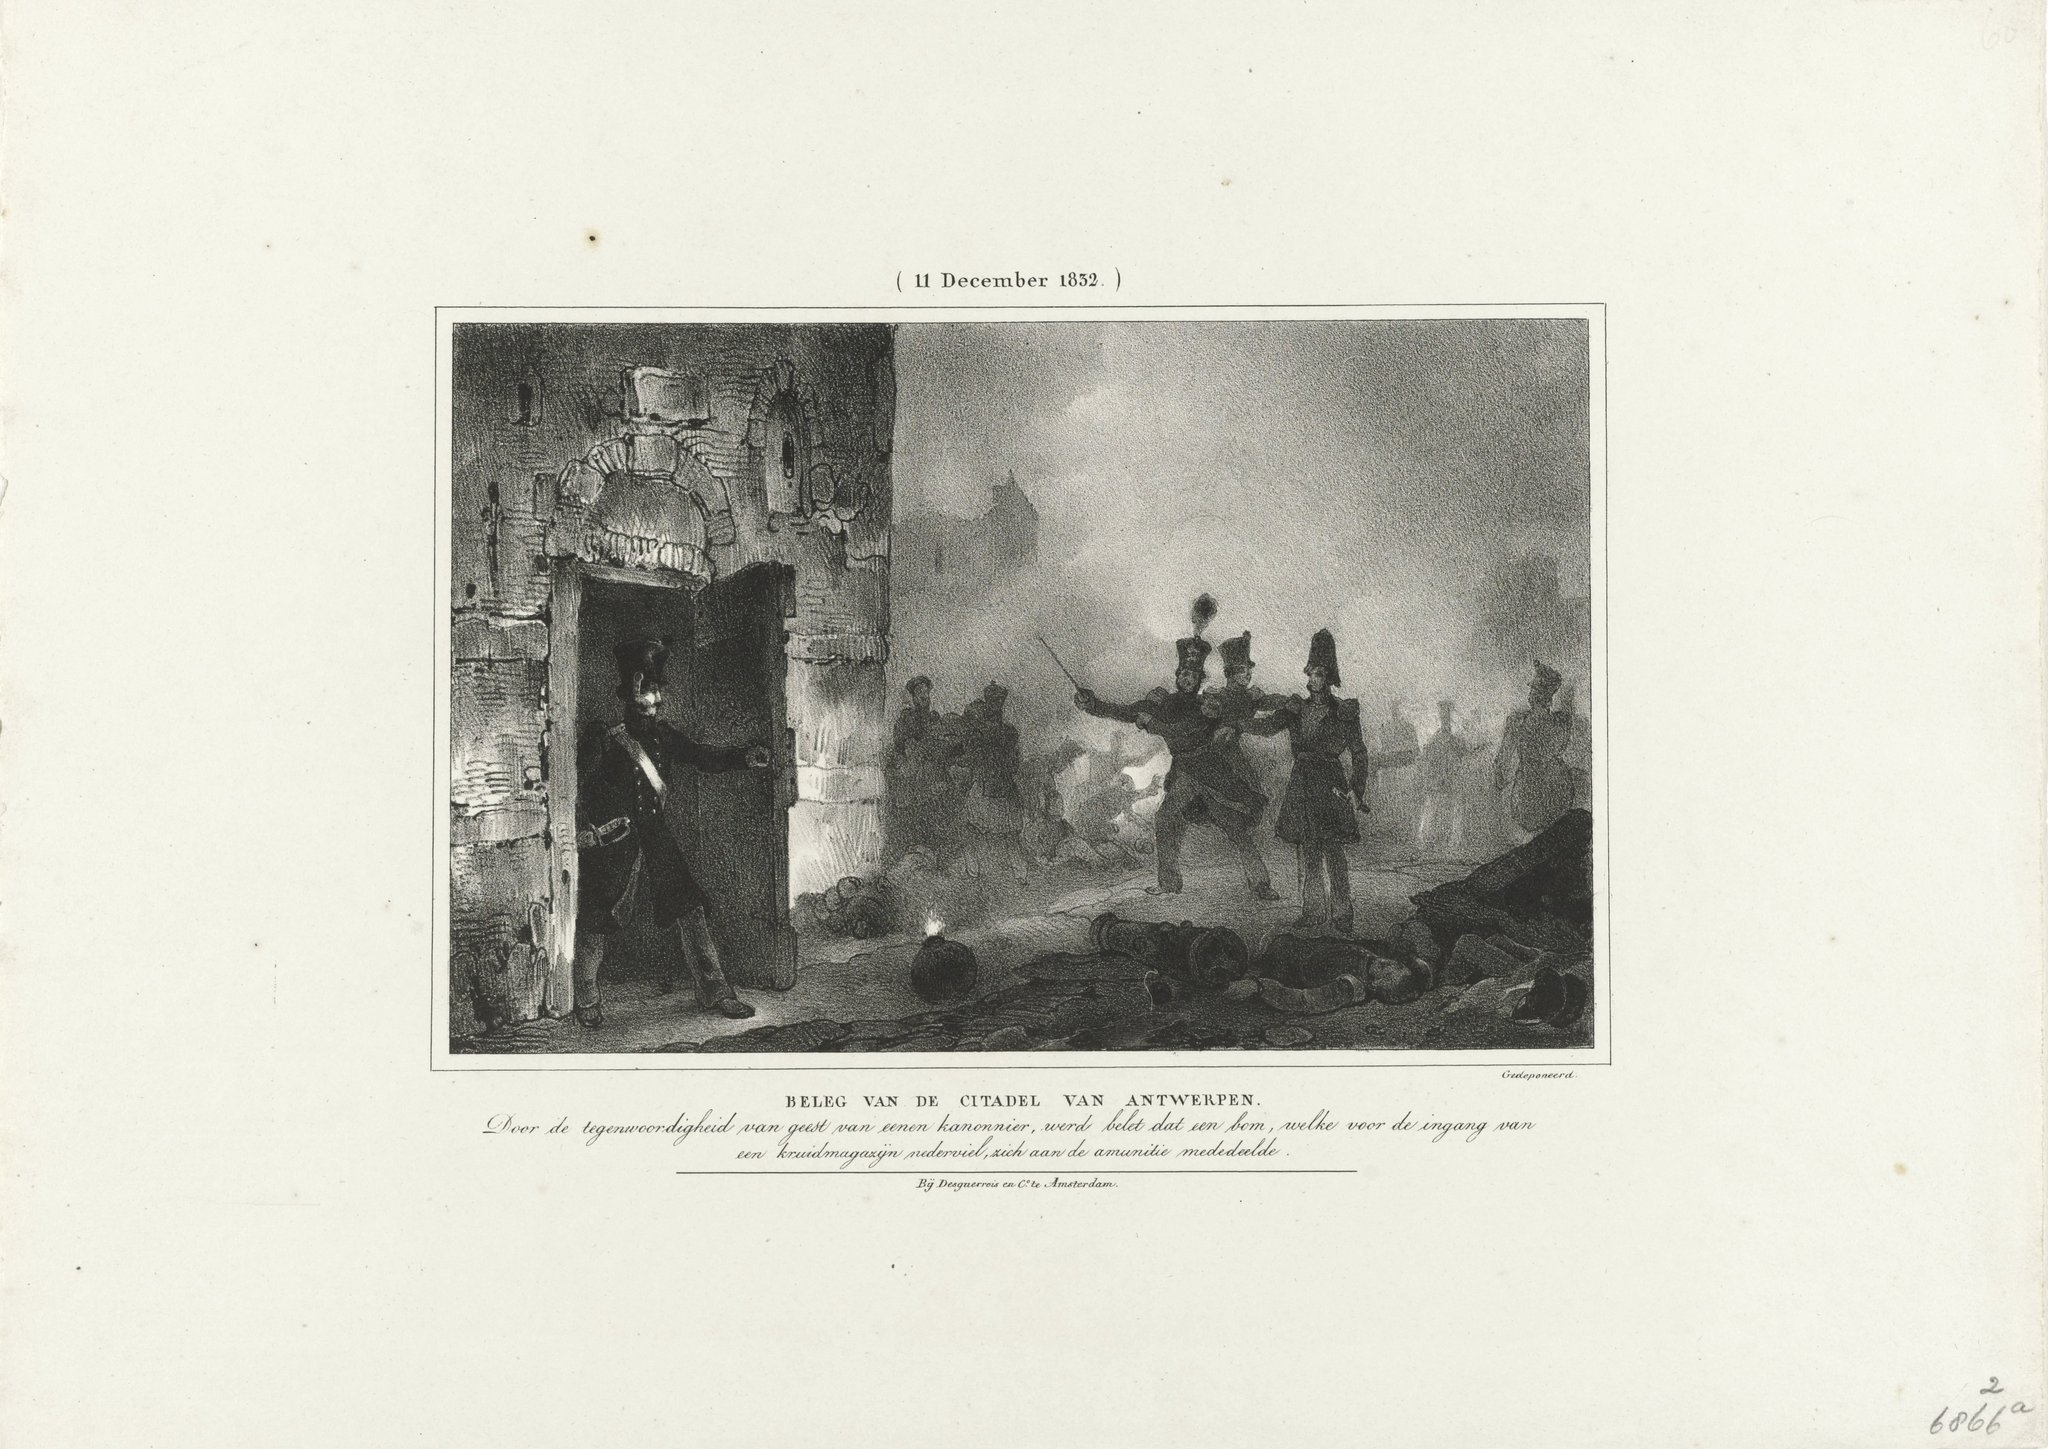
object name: print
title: Vier platen van de verdediging van de Citadel 10-18 december 1832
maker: johannes steyn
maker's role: print maker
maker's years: 1805-1840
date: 1832-1833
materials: paper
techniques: lithograph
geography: amsterdam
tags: fortress, bombardment ~ siege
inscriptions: : ‘Gedeponeerd’, collector's mark: Lugt 2228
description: Een kanonnier voorkomt dat een bom het kruitmagazijn bereikt, 11 december 1832. Onderdeel van een serie van vier platen van de Nederlandse verdediging tijdens het beleg van de Citadel van Antwerpen door het Franse leger, december 1832.